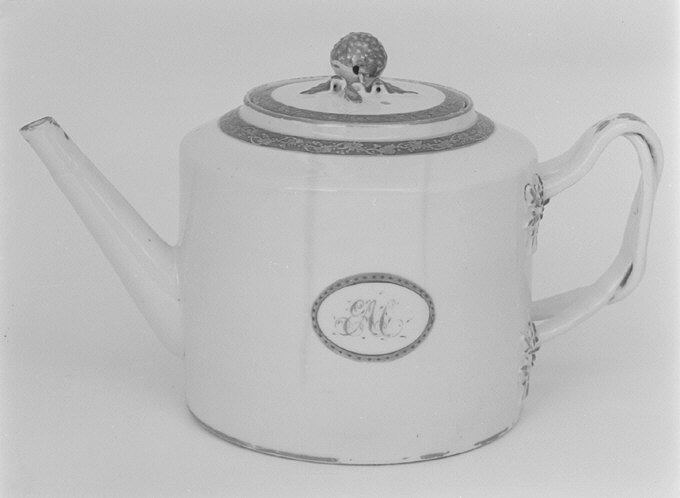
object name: teapot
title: Teapot (part of a service)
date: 1790-1800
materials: hard paste porcelain